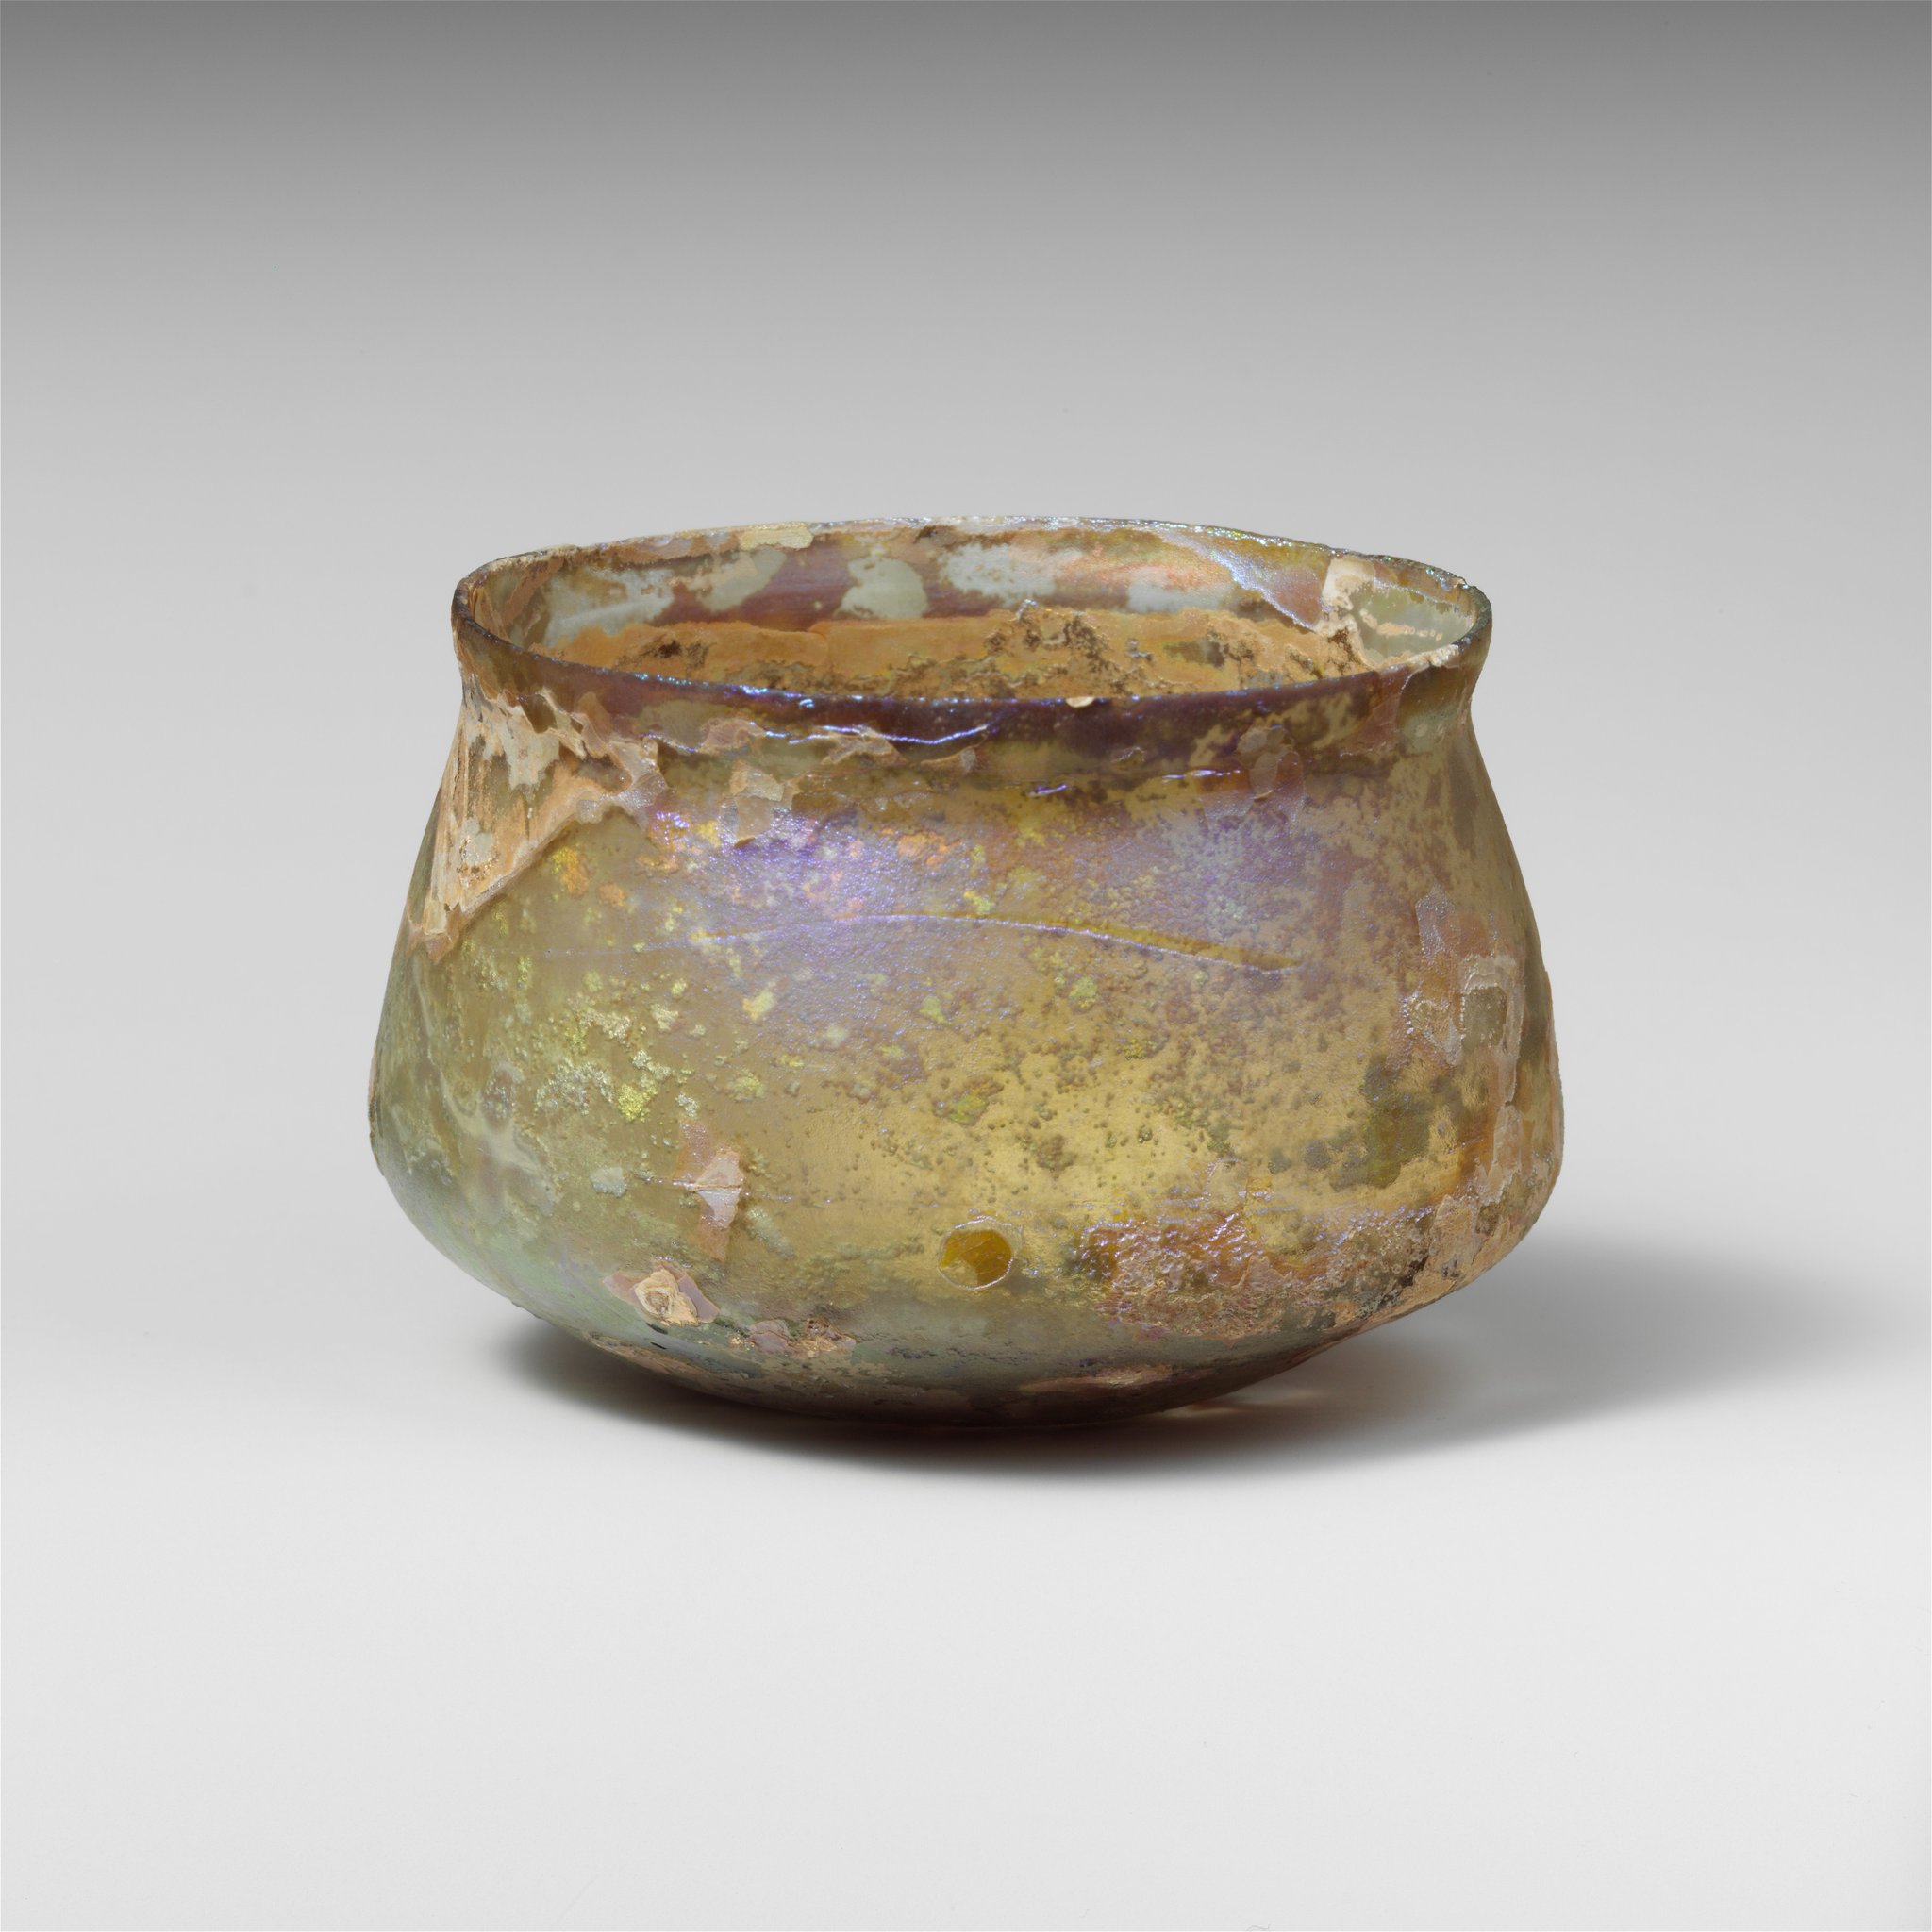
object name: cup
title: Glass cup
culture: roman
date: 101-300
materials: glass